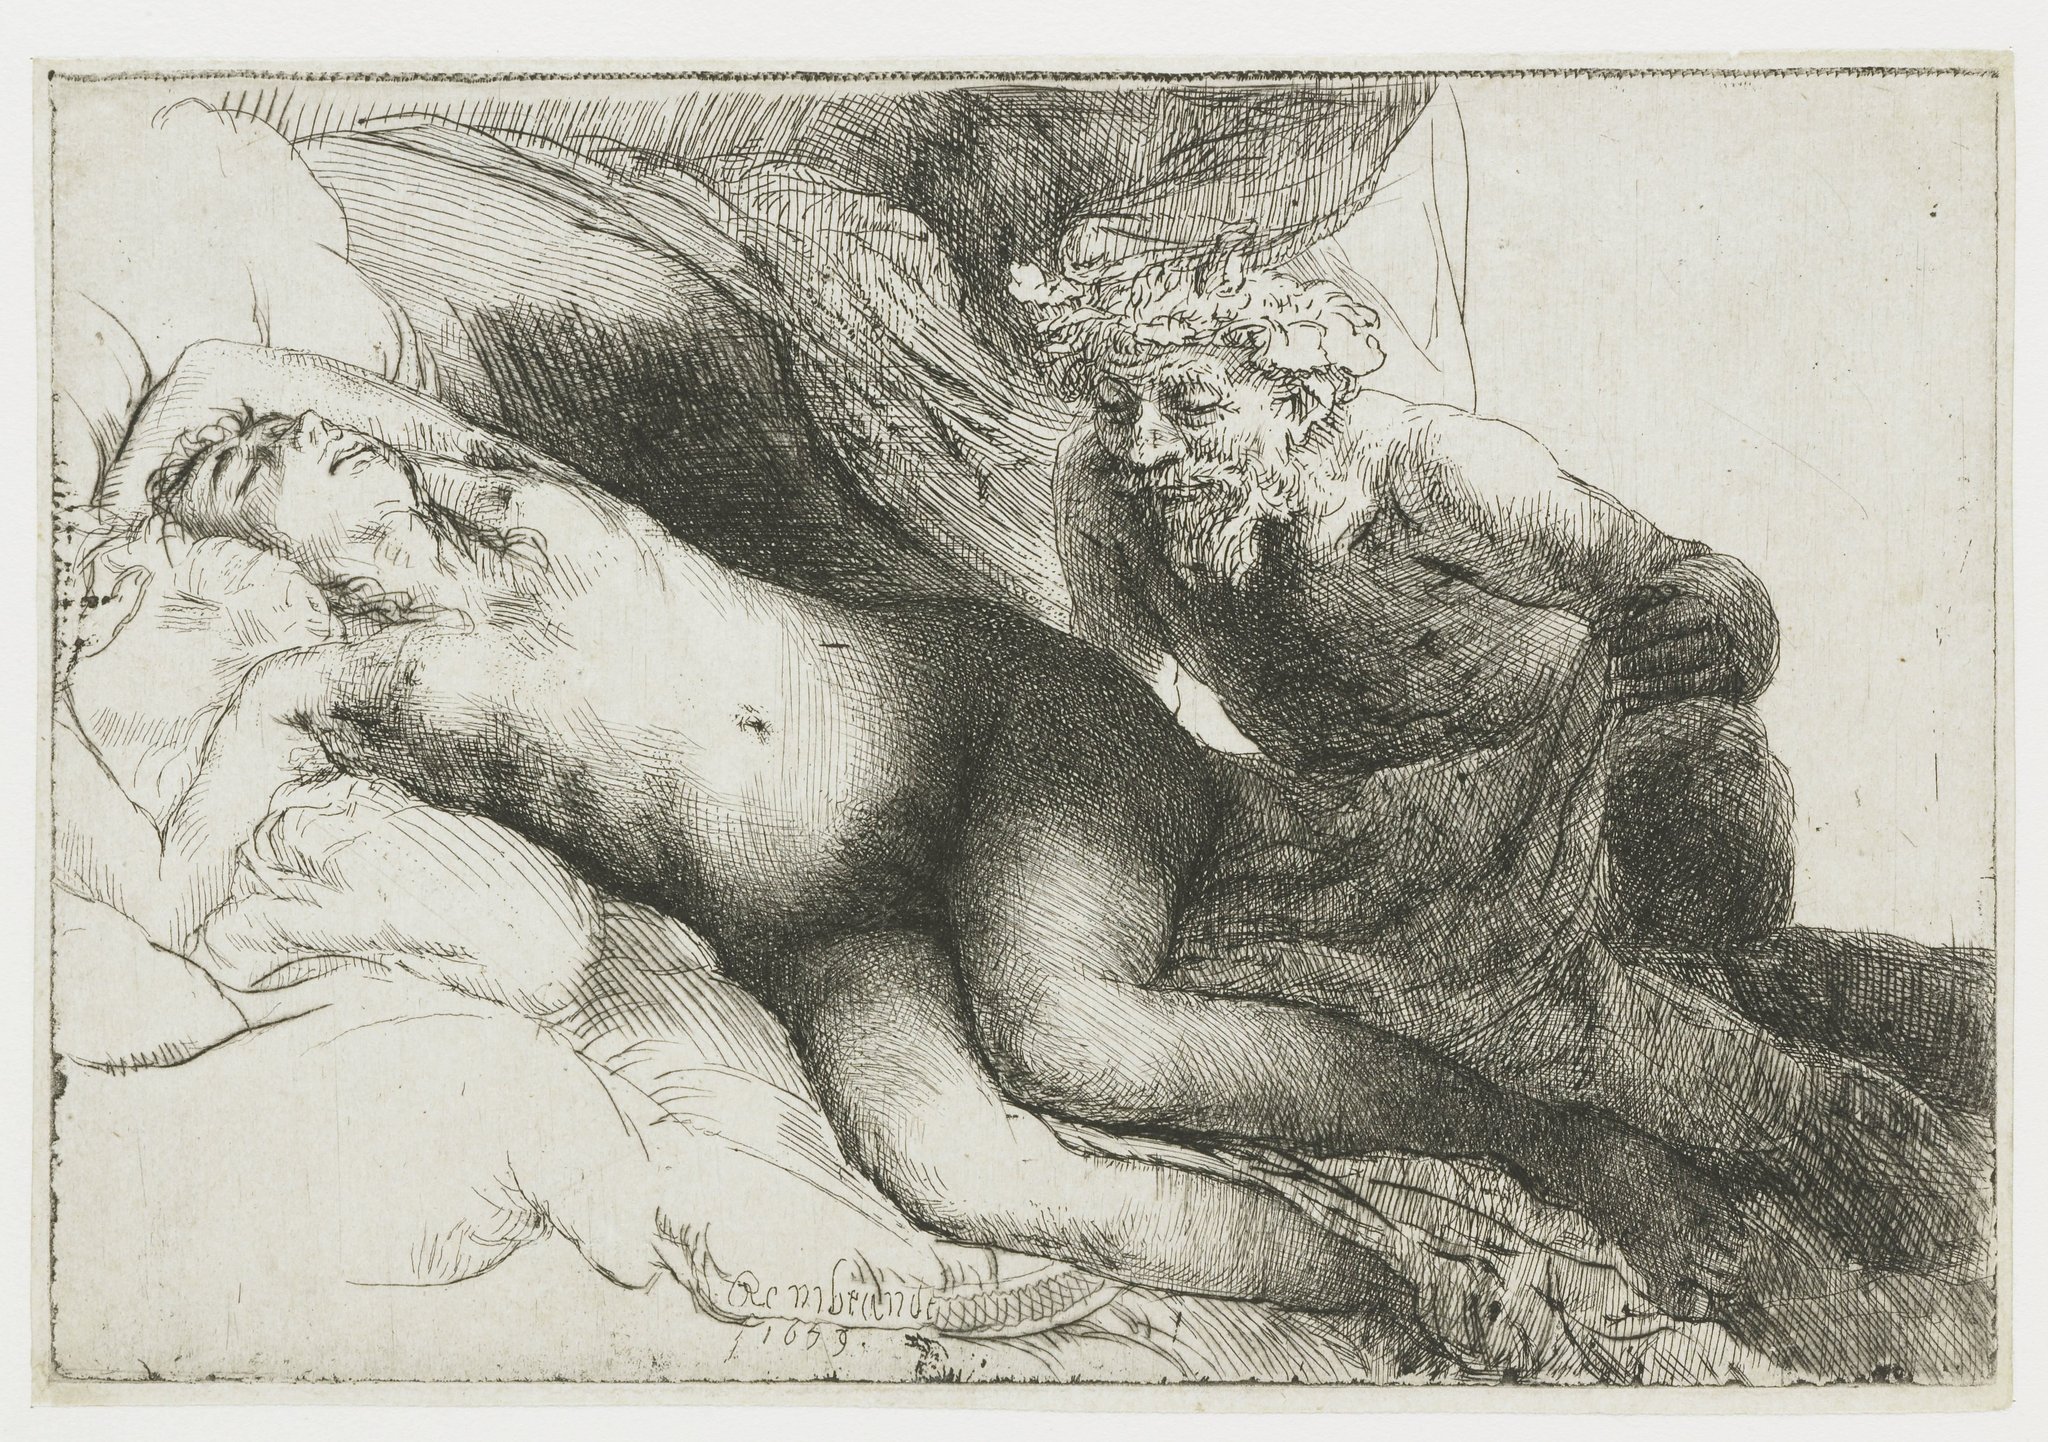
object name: print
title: Jupiter and Antiope: the larger plate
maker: rembrandt van rijn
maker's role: draughtsman, painter, print maker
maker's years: 1606-1669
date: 1659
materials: paper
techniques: drypoint, etching, intaglio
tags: jupiter, disguised as a satyr, approaches the sleeping antiope; the eagle may be standing nearby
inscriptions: signature and date: ‘Rembrandt f 1659’, mark: Lugt 2228, mark: Lugt 301, mark: ‘S.C. in een ovaal met de letters BRITISH MUSEUM DUPLICATE’ Lugt 305